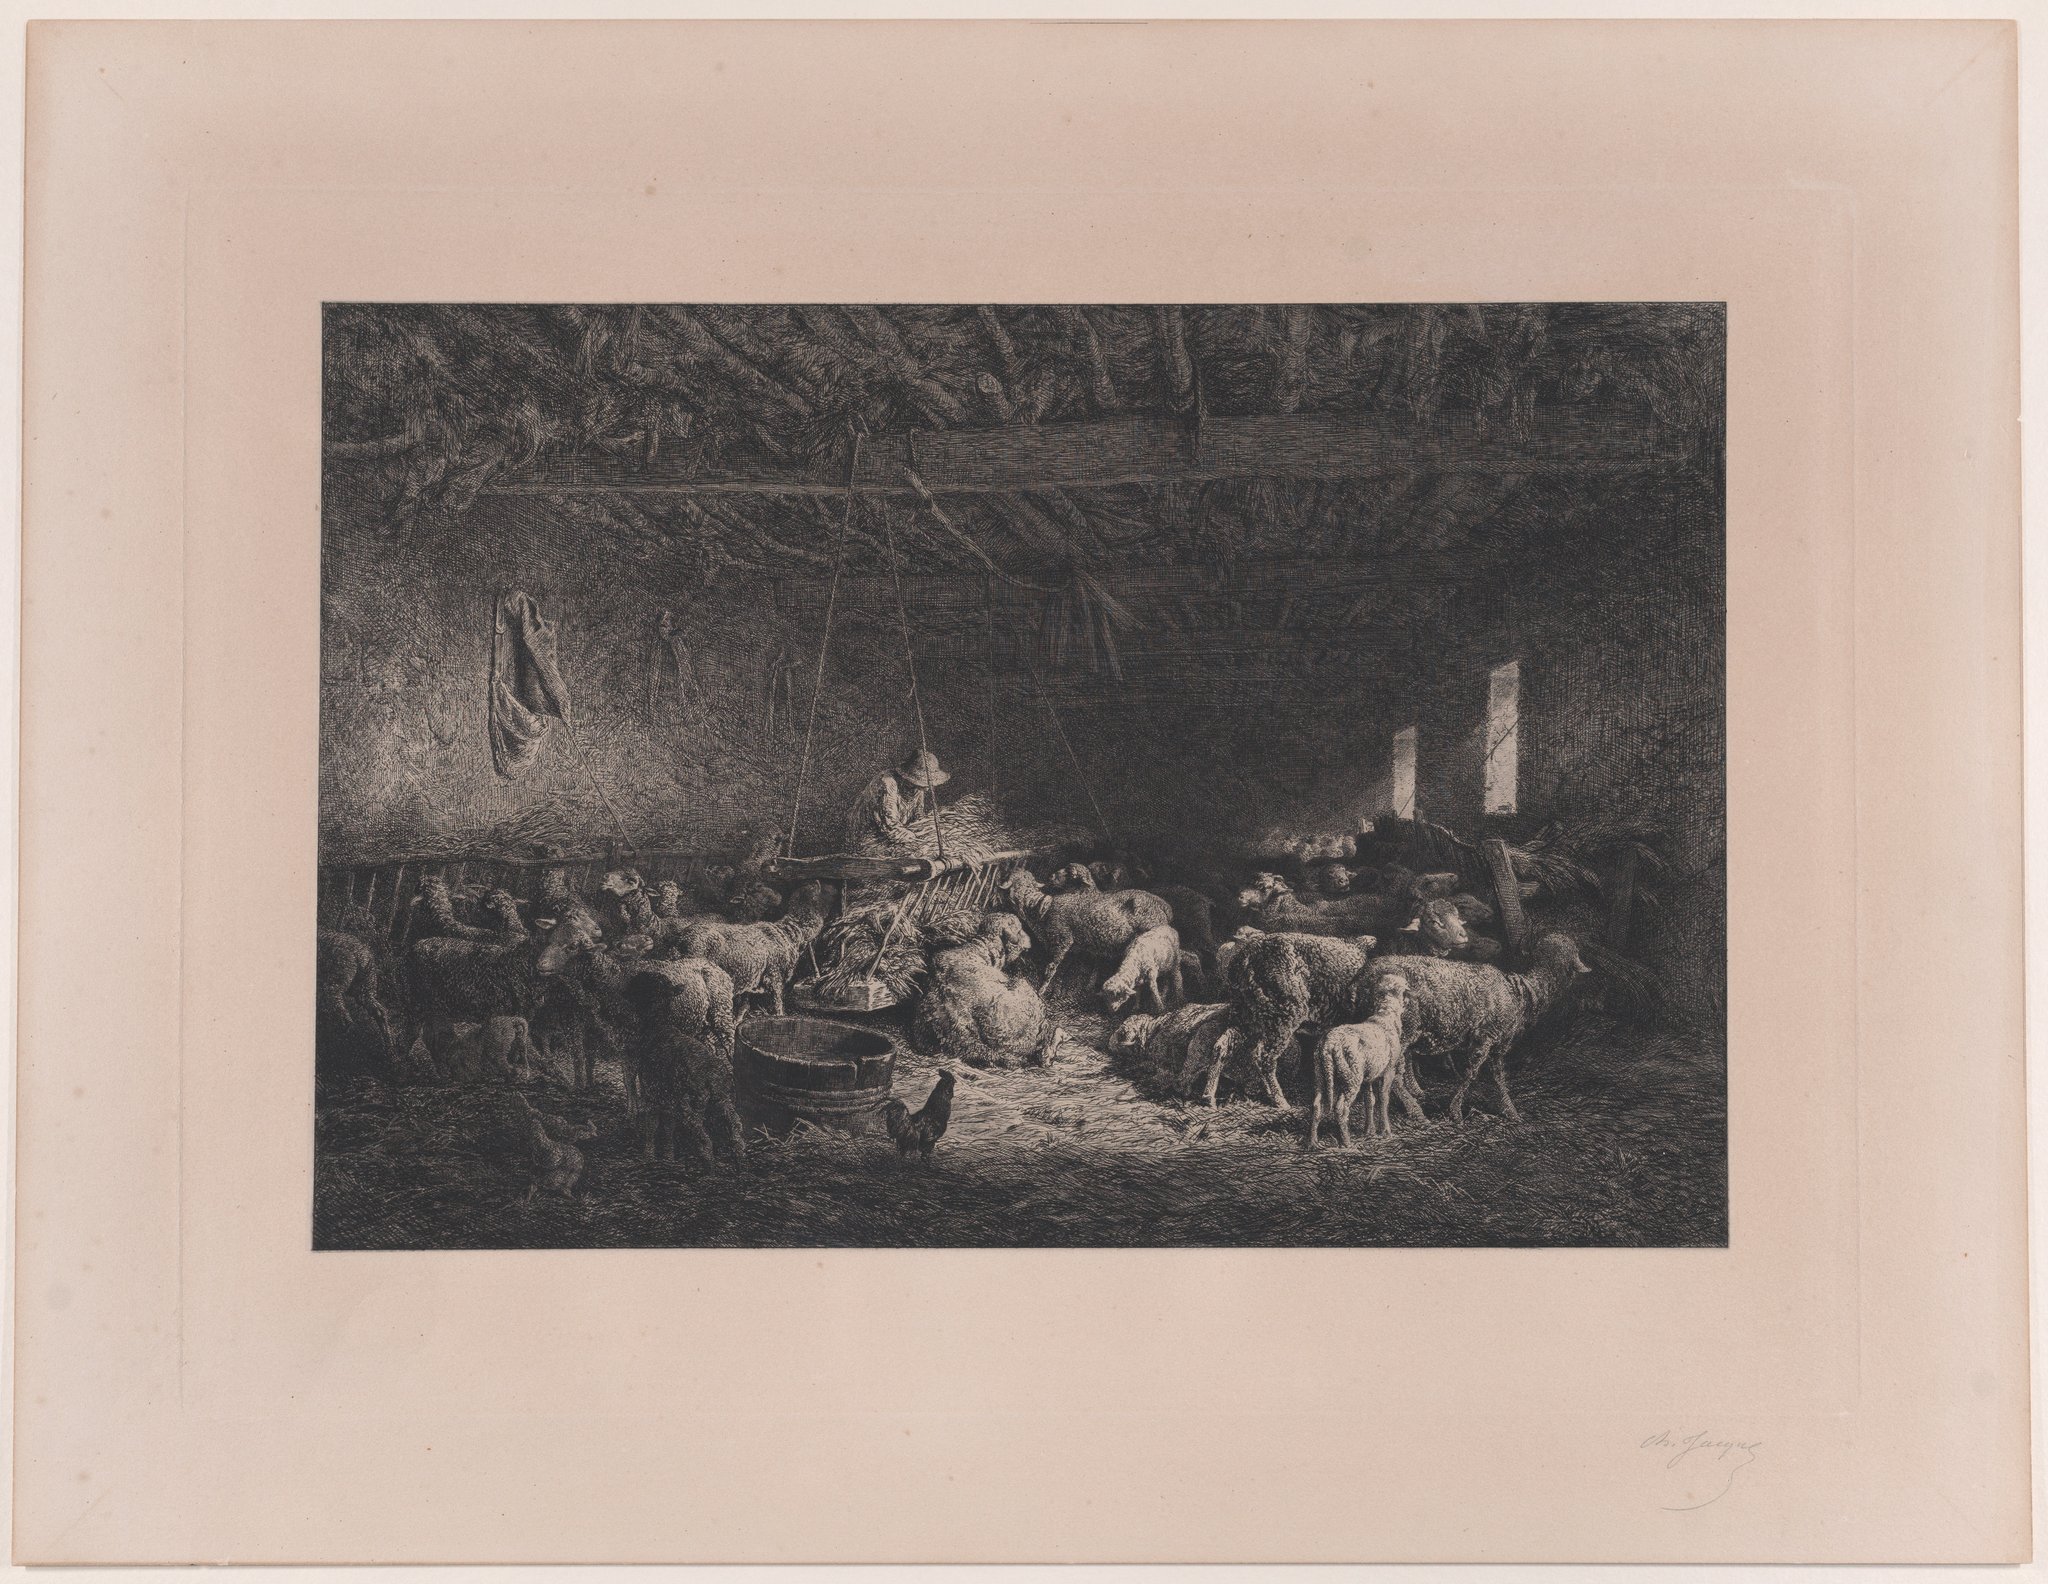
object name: print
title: Interior of a Sheepfold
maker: charles émile jacque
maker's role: artist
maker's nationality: french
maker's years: 1813-1894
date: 1866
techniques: drypoint